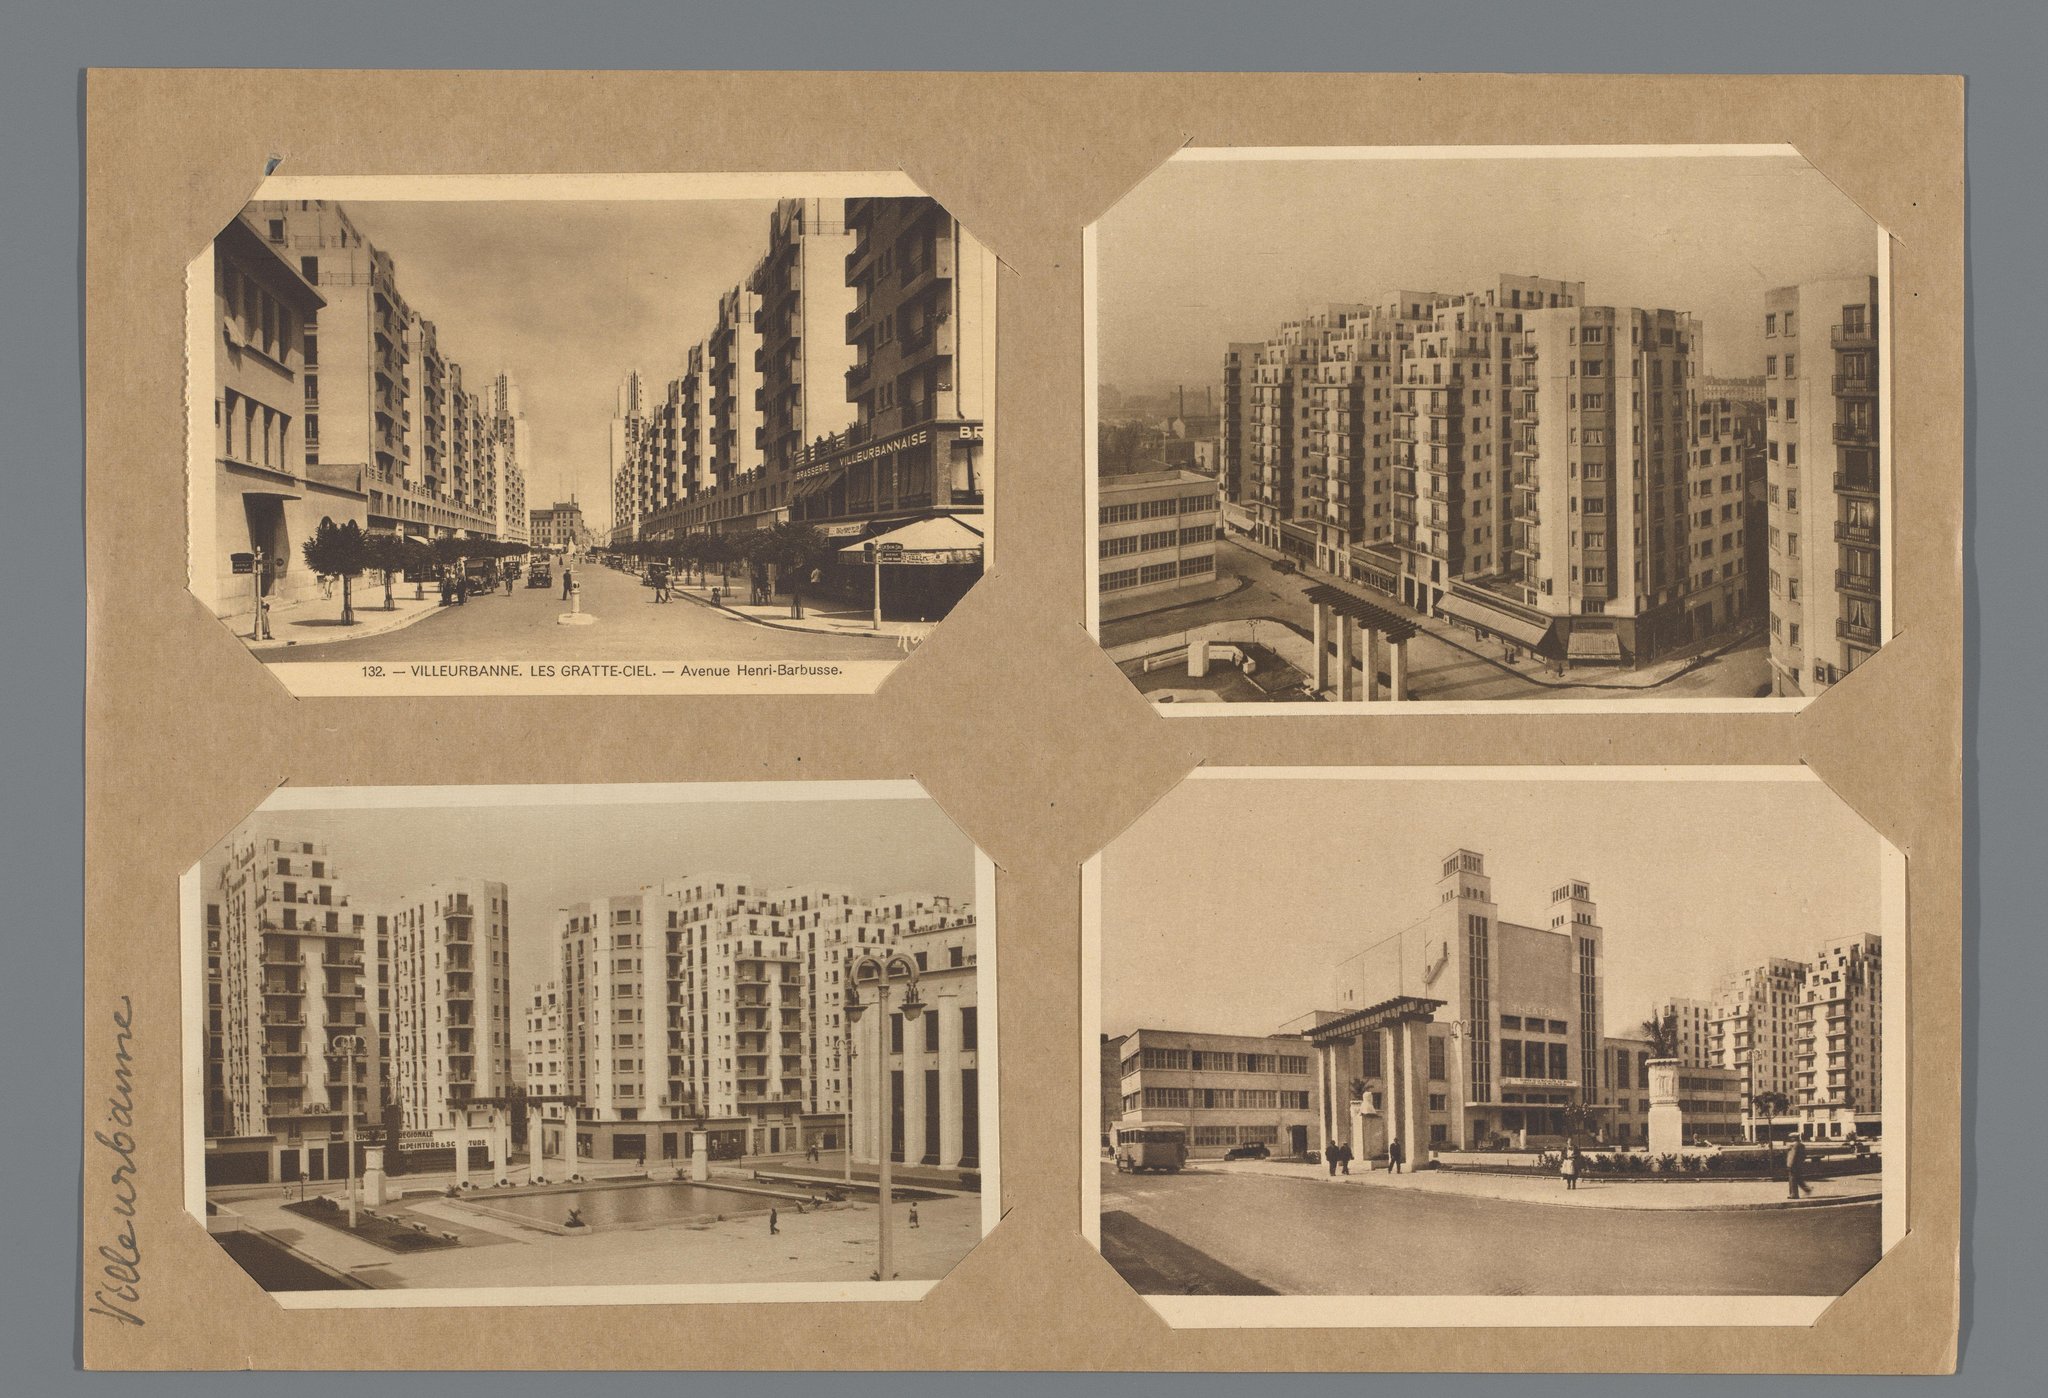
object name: photograph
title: Villeurbanne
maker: Anonymous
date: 1900-1950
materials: paper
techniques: rotogravure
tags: villeurbanne